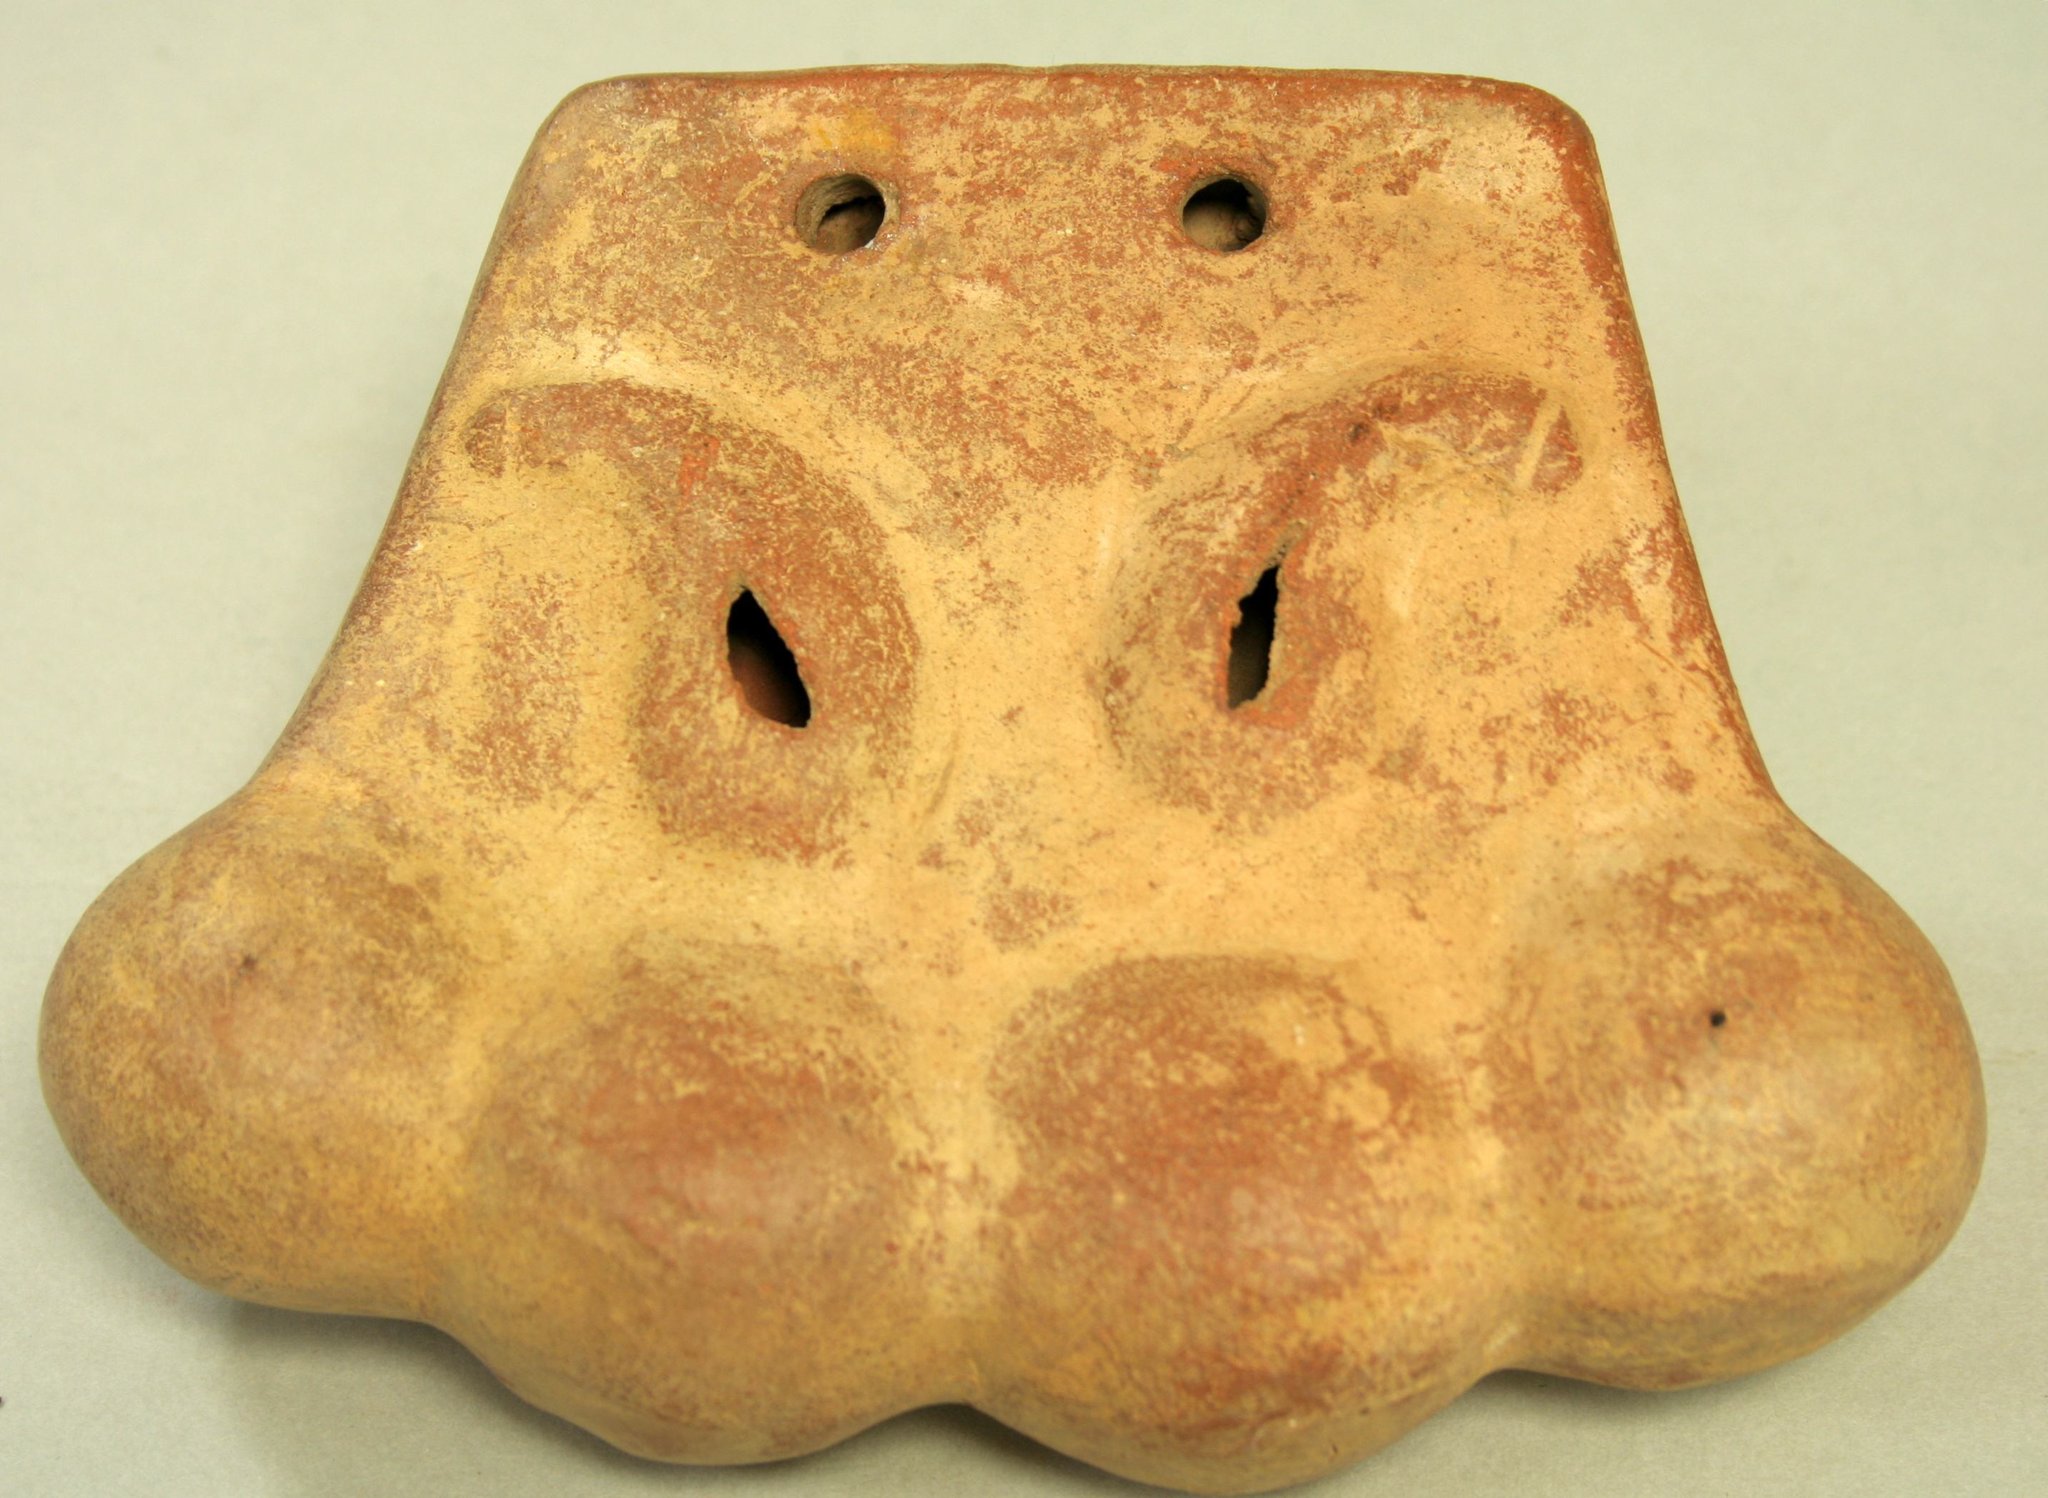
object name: belt ornament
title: Belt Ornament Rattle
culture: moche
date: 101-700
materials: ceramic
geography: peru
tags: musical instruments